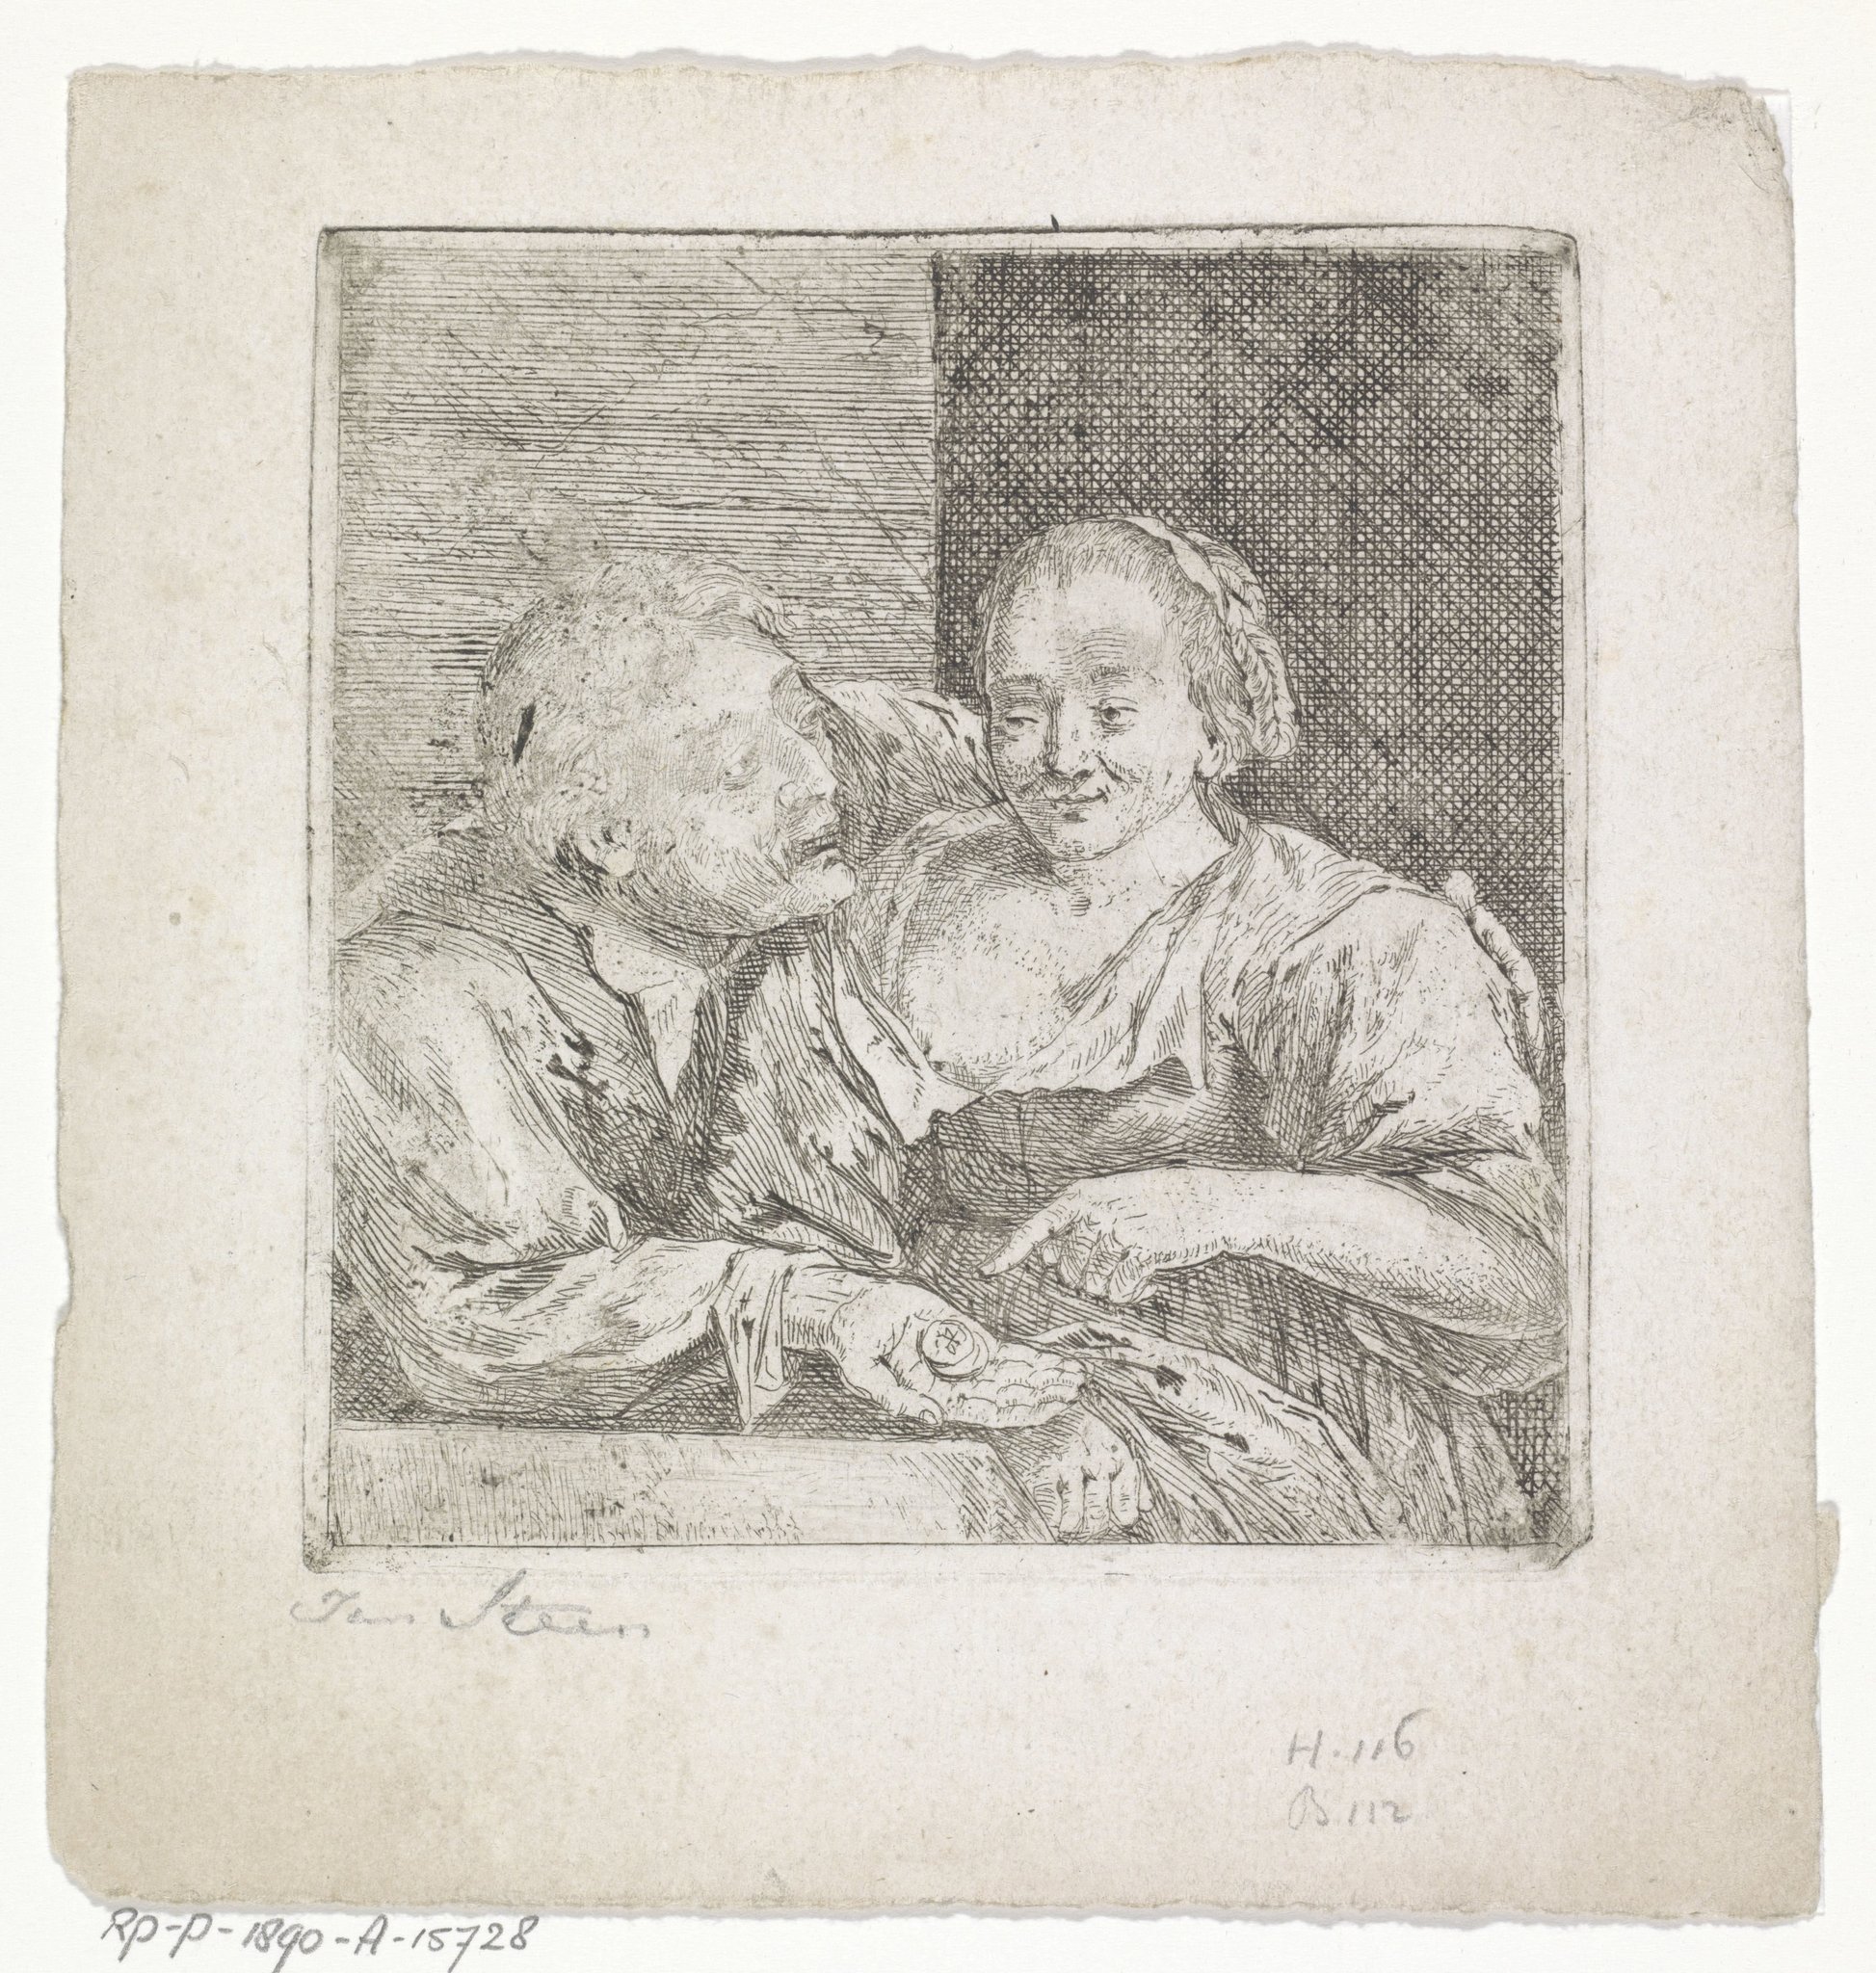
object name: print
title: Man biedt een prostituee geld aan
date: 1640-1690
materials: paper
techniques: engraving, etching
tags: unequal couple, ill-matched couple, prostitution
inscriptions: collector's mark: Lugt 2228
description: Een man omarmt een prostituee, van wie een borst zichtbaar is, en biedt haar muntstukken aan. Zij wijst op de munten.